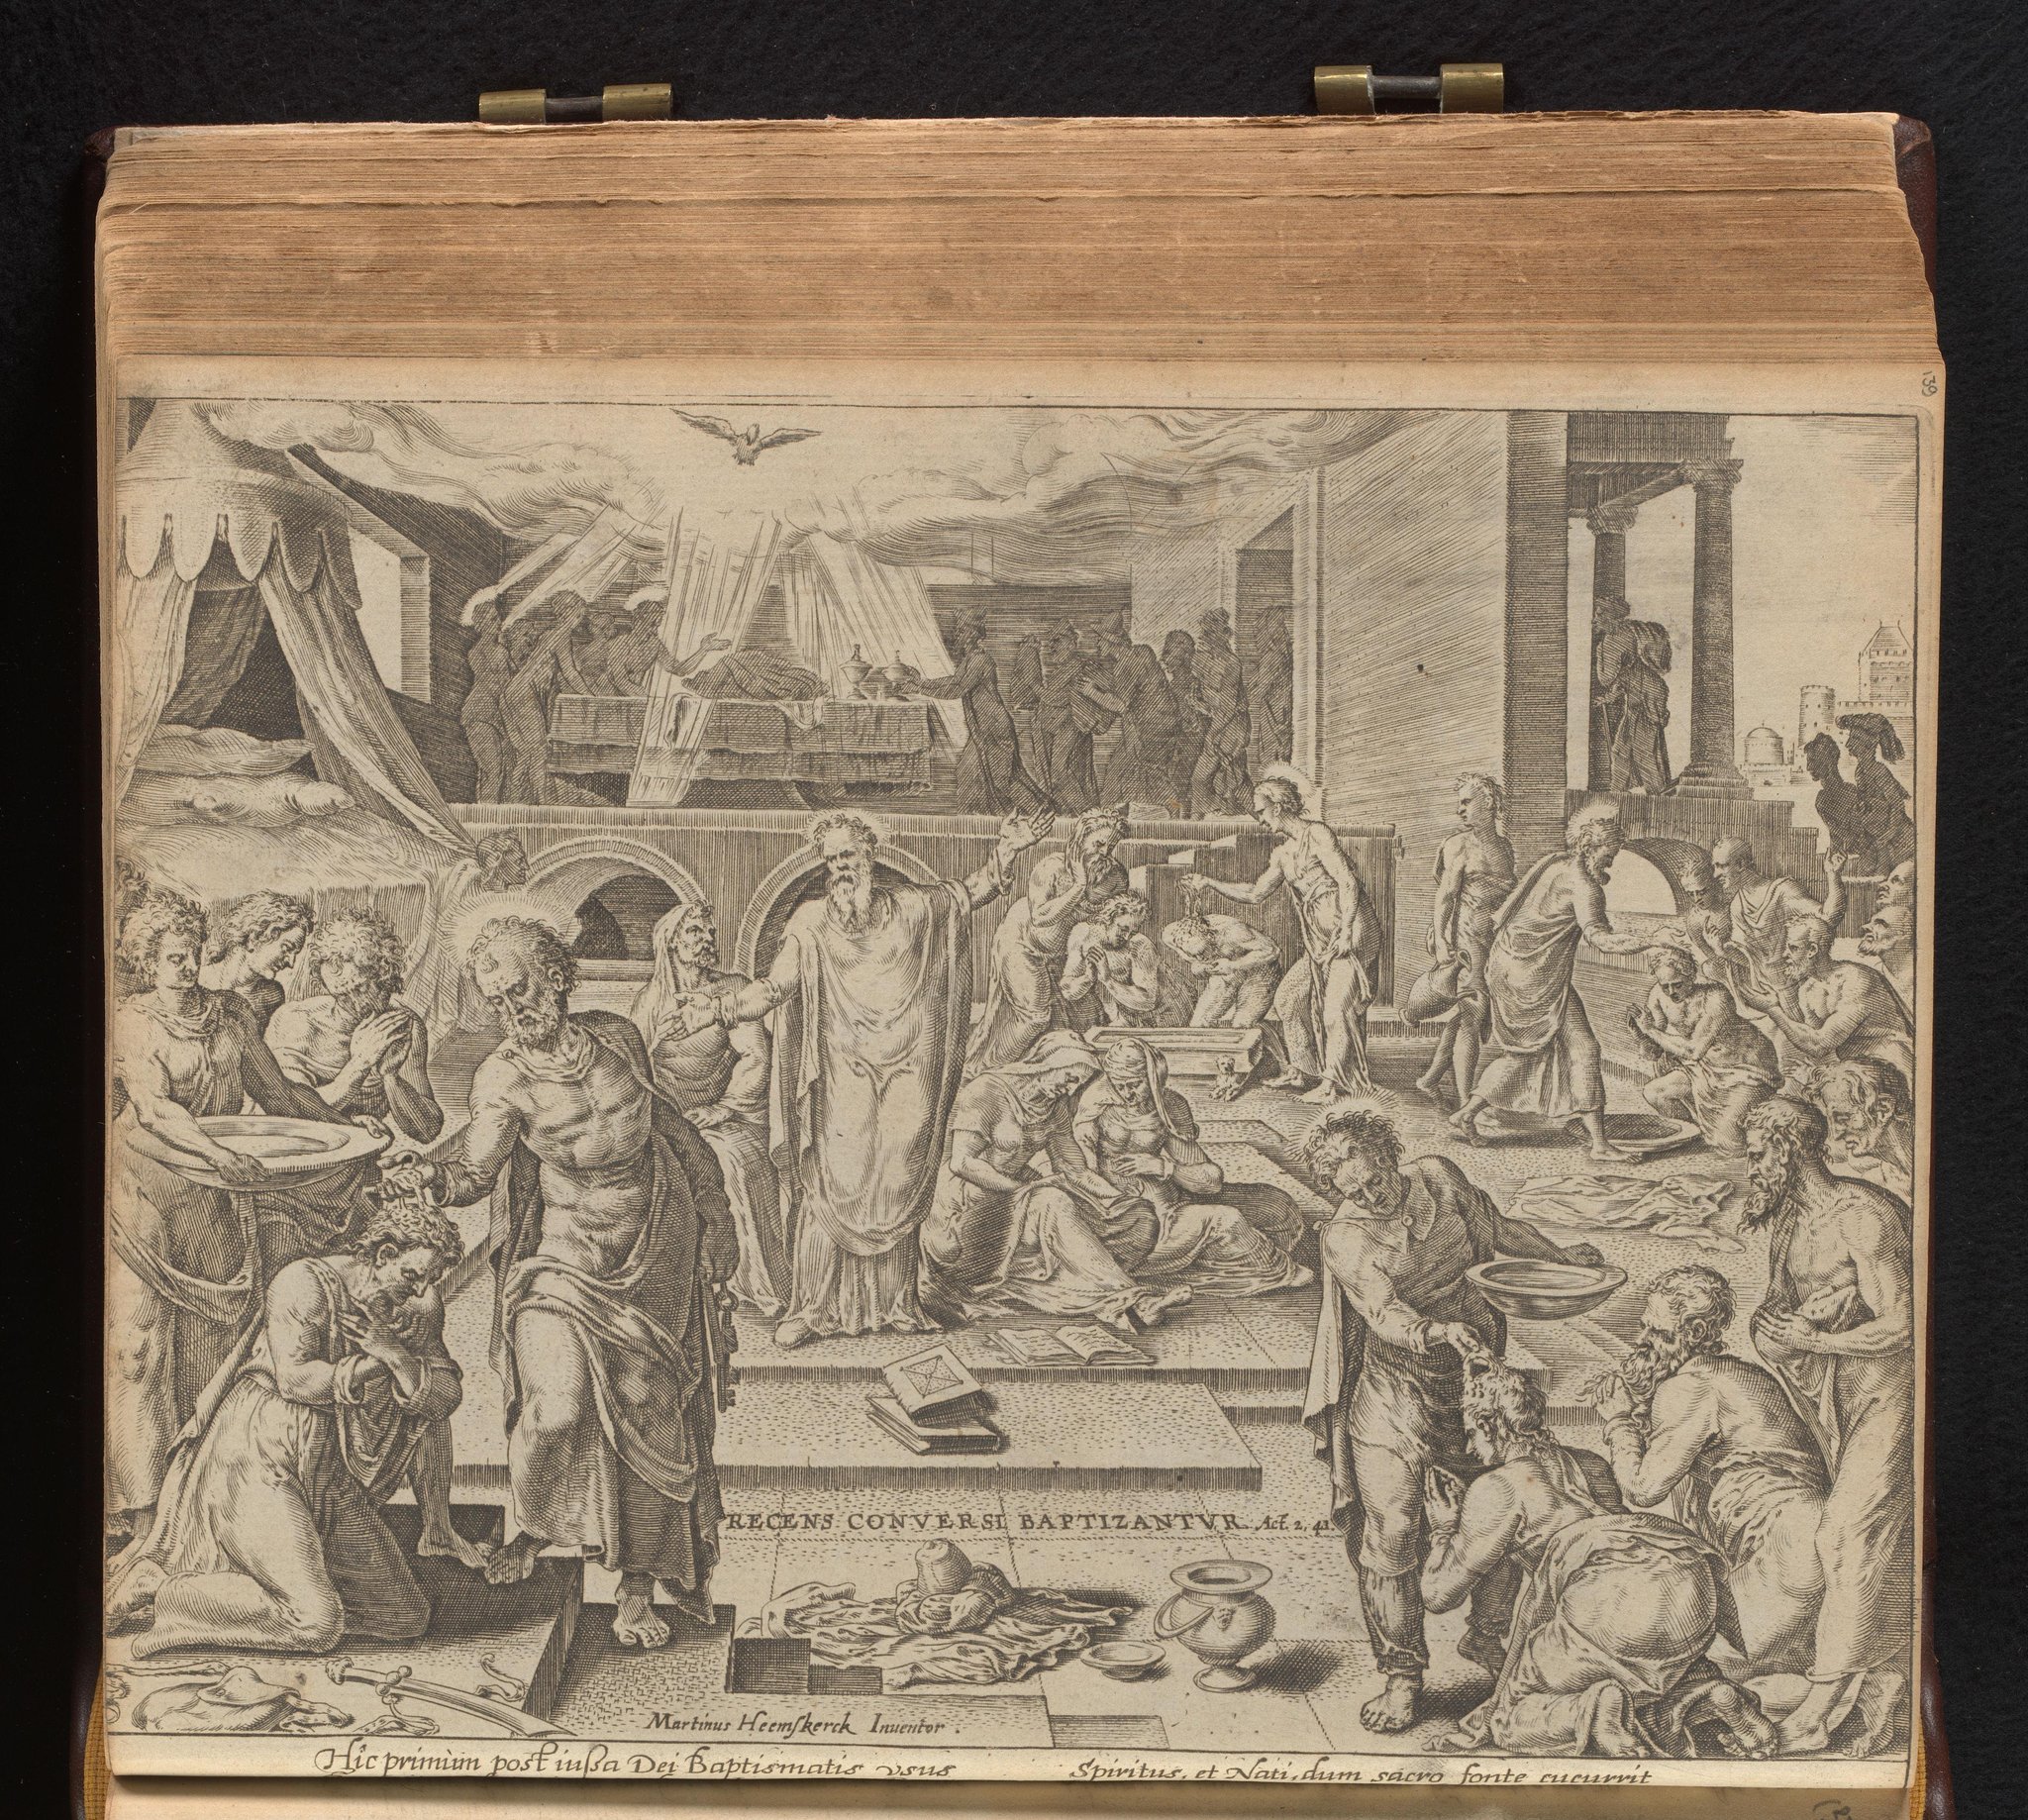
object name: titelprent, frontispice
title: Acta Apostolorum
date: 1575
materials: paper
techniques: engraving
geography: antwerp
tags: peter and the other apostles baptize, pentecost: the holy ghost descends upon (mary and) the apostles, sometimes paul and/or representatives of the nations present (acts 2:1-4)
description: Prent maakt deel uit van een prentbijbel.